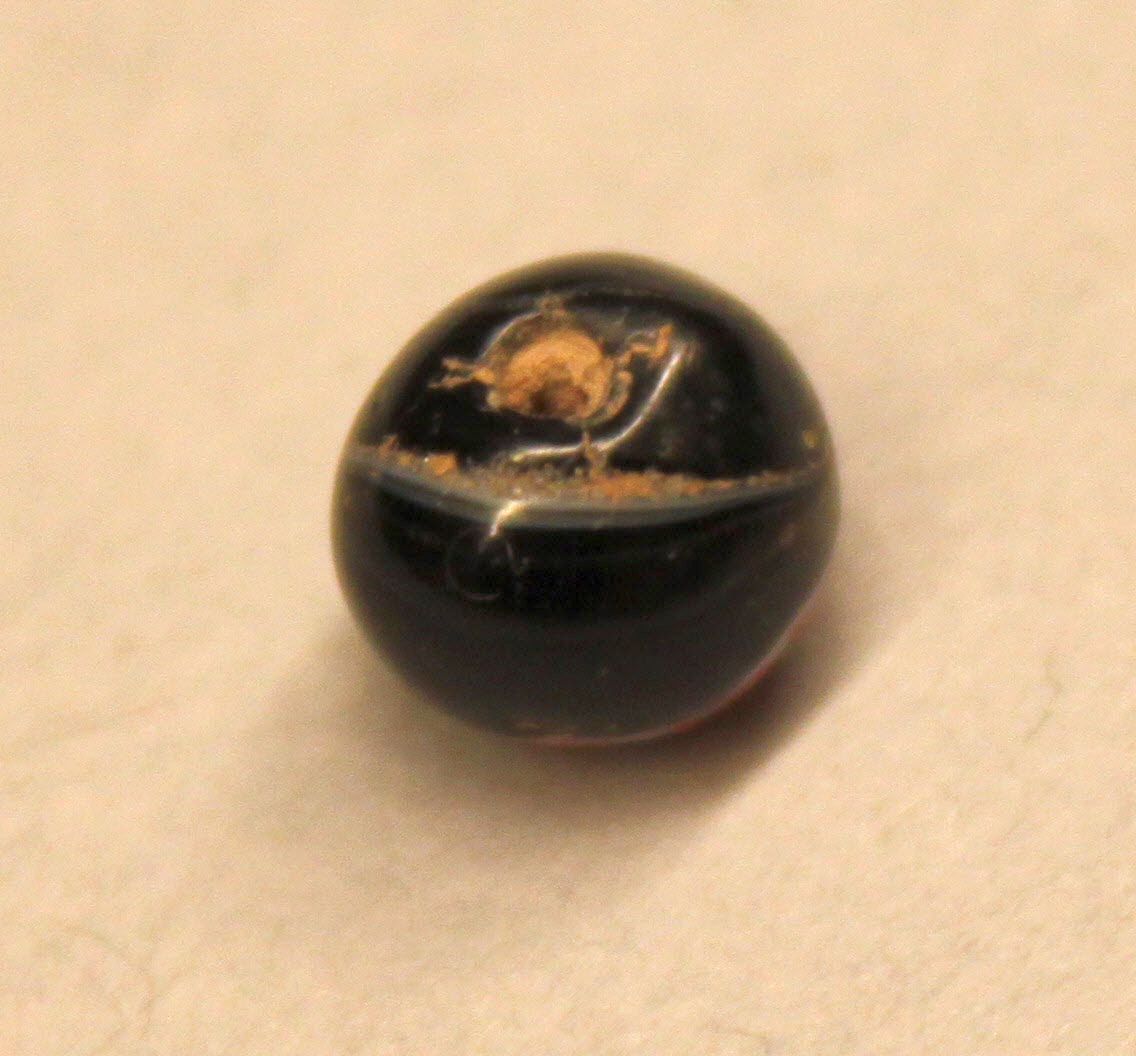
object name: bead and pendant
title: Beads and Pendants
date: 701-1300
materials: stone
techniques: cutting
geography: iran